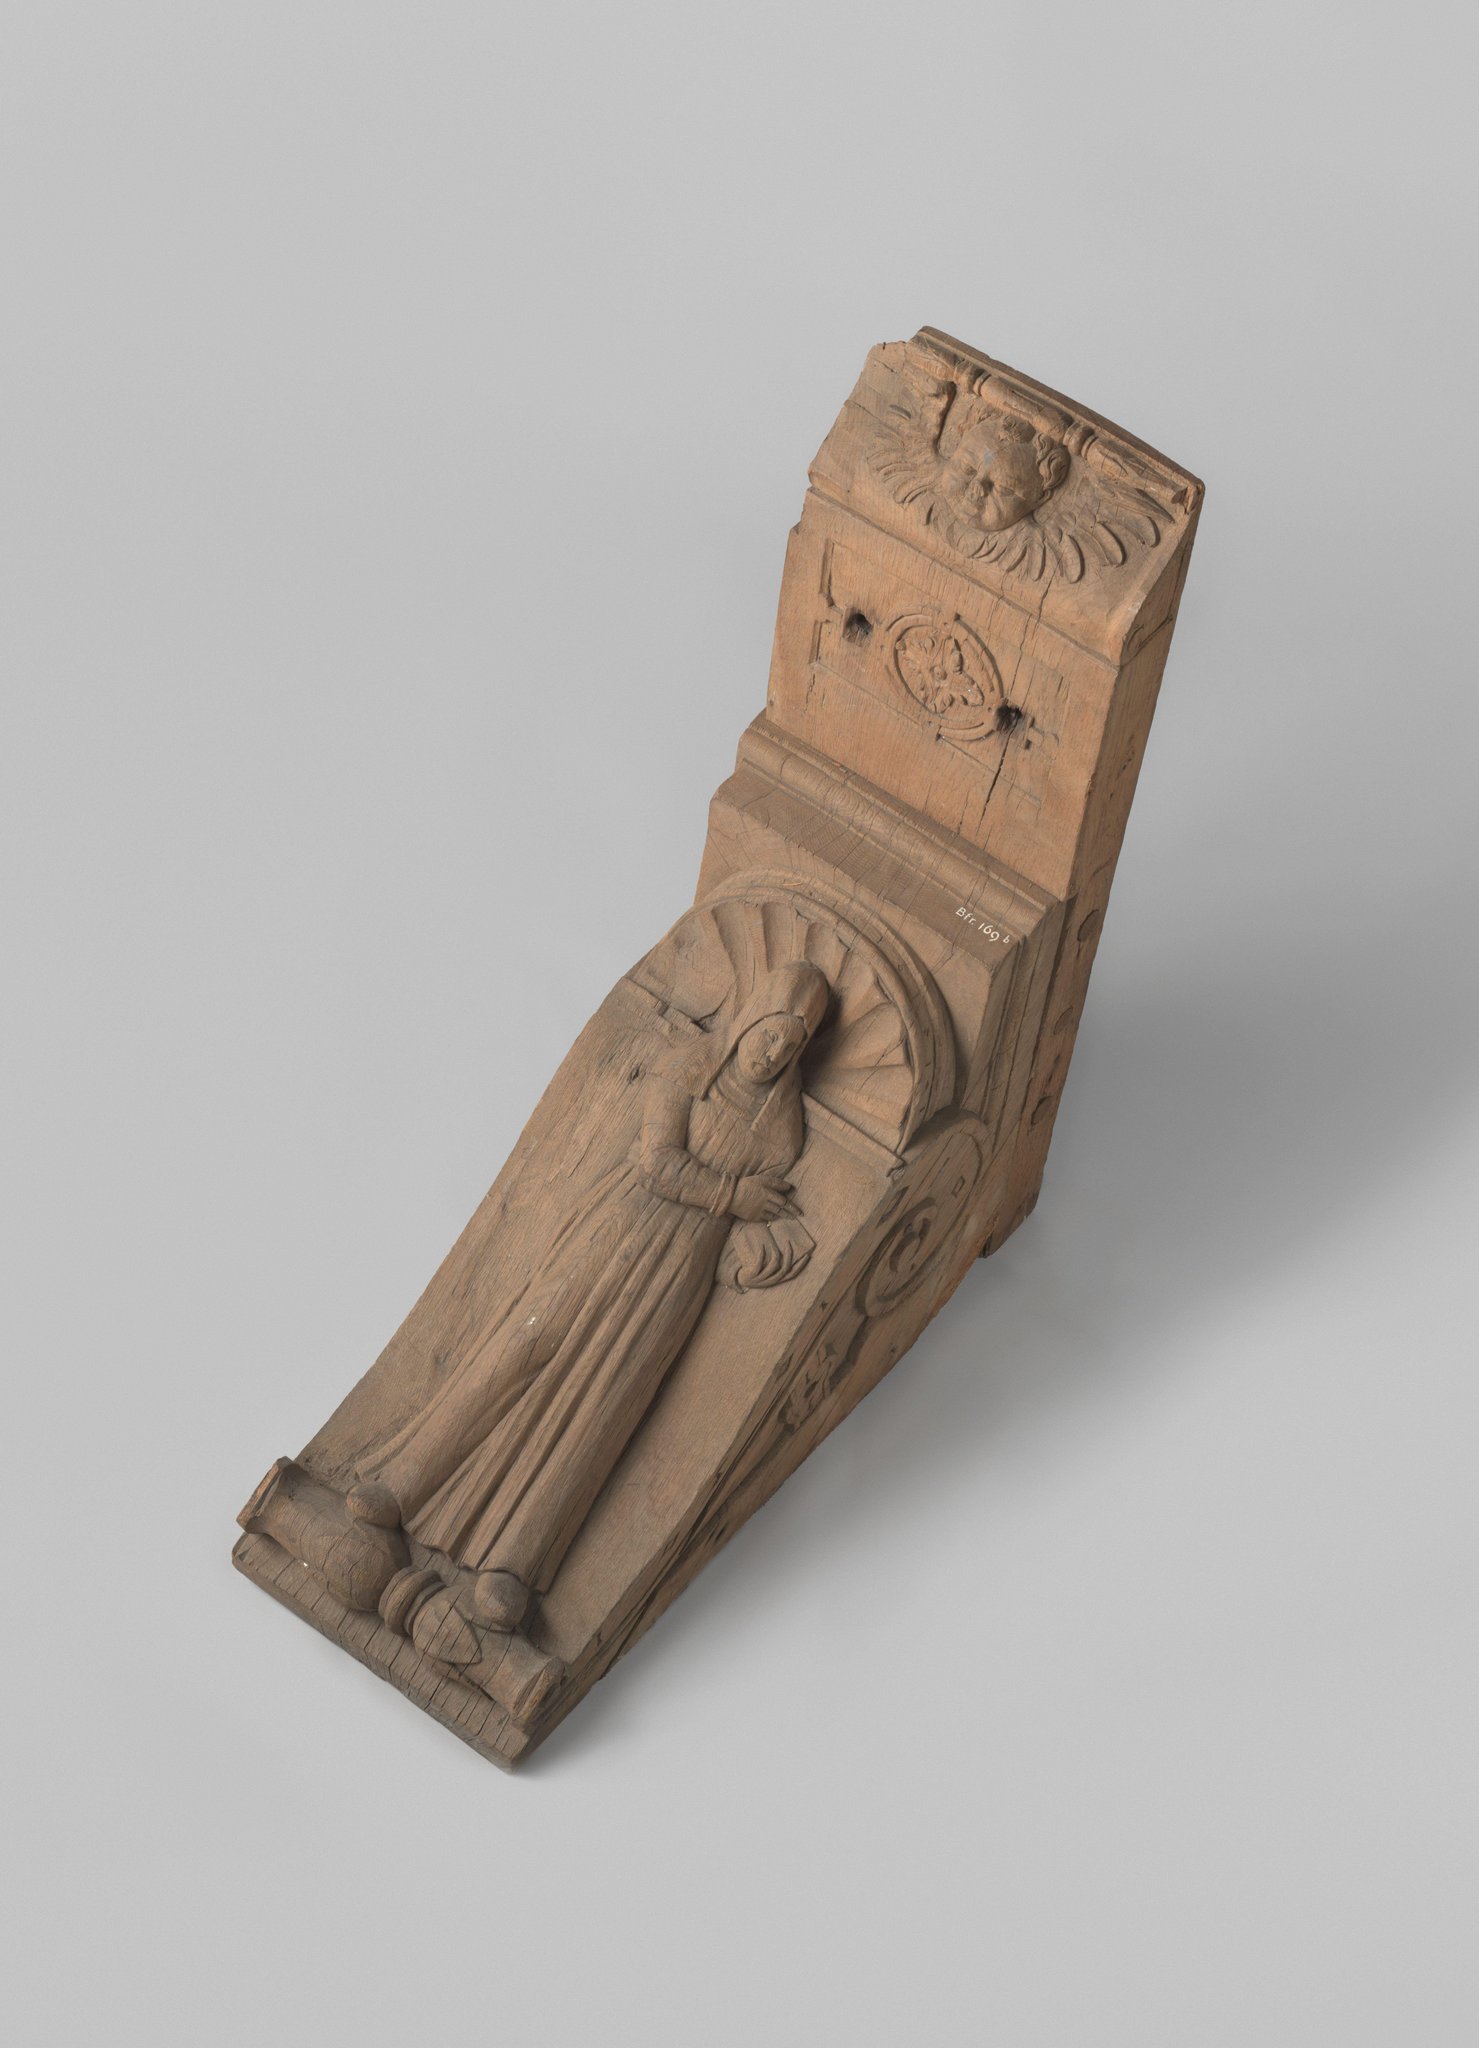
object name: korbeel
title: Korbeel met sleutelstuk, met gesneden voorstelling van een non, afkomstig uit het klooster in de Oude Hoogstraat te Amsterdam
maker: Anonymous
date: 1550-1600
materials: wood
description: Korbeel en sleutelstuk van eikenhout. Op het consolevormige voorstuk is in reliëf een non voor een schelpnis gebeeldhouwd. De zijkanten vertonen een voluut met rolwerk. Het sleutelstuk is versierd met een engelenkop. Afkomstig uit het klooster in de Oude Hoogstraat te Amsterdam.